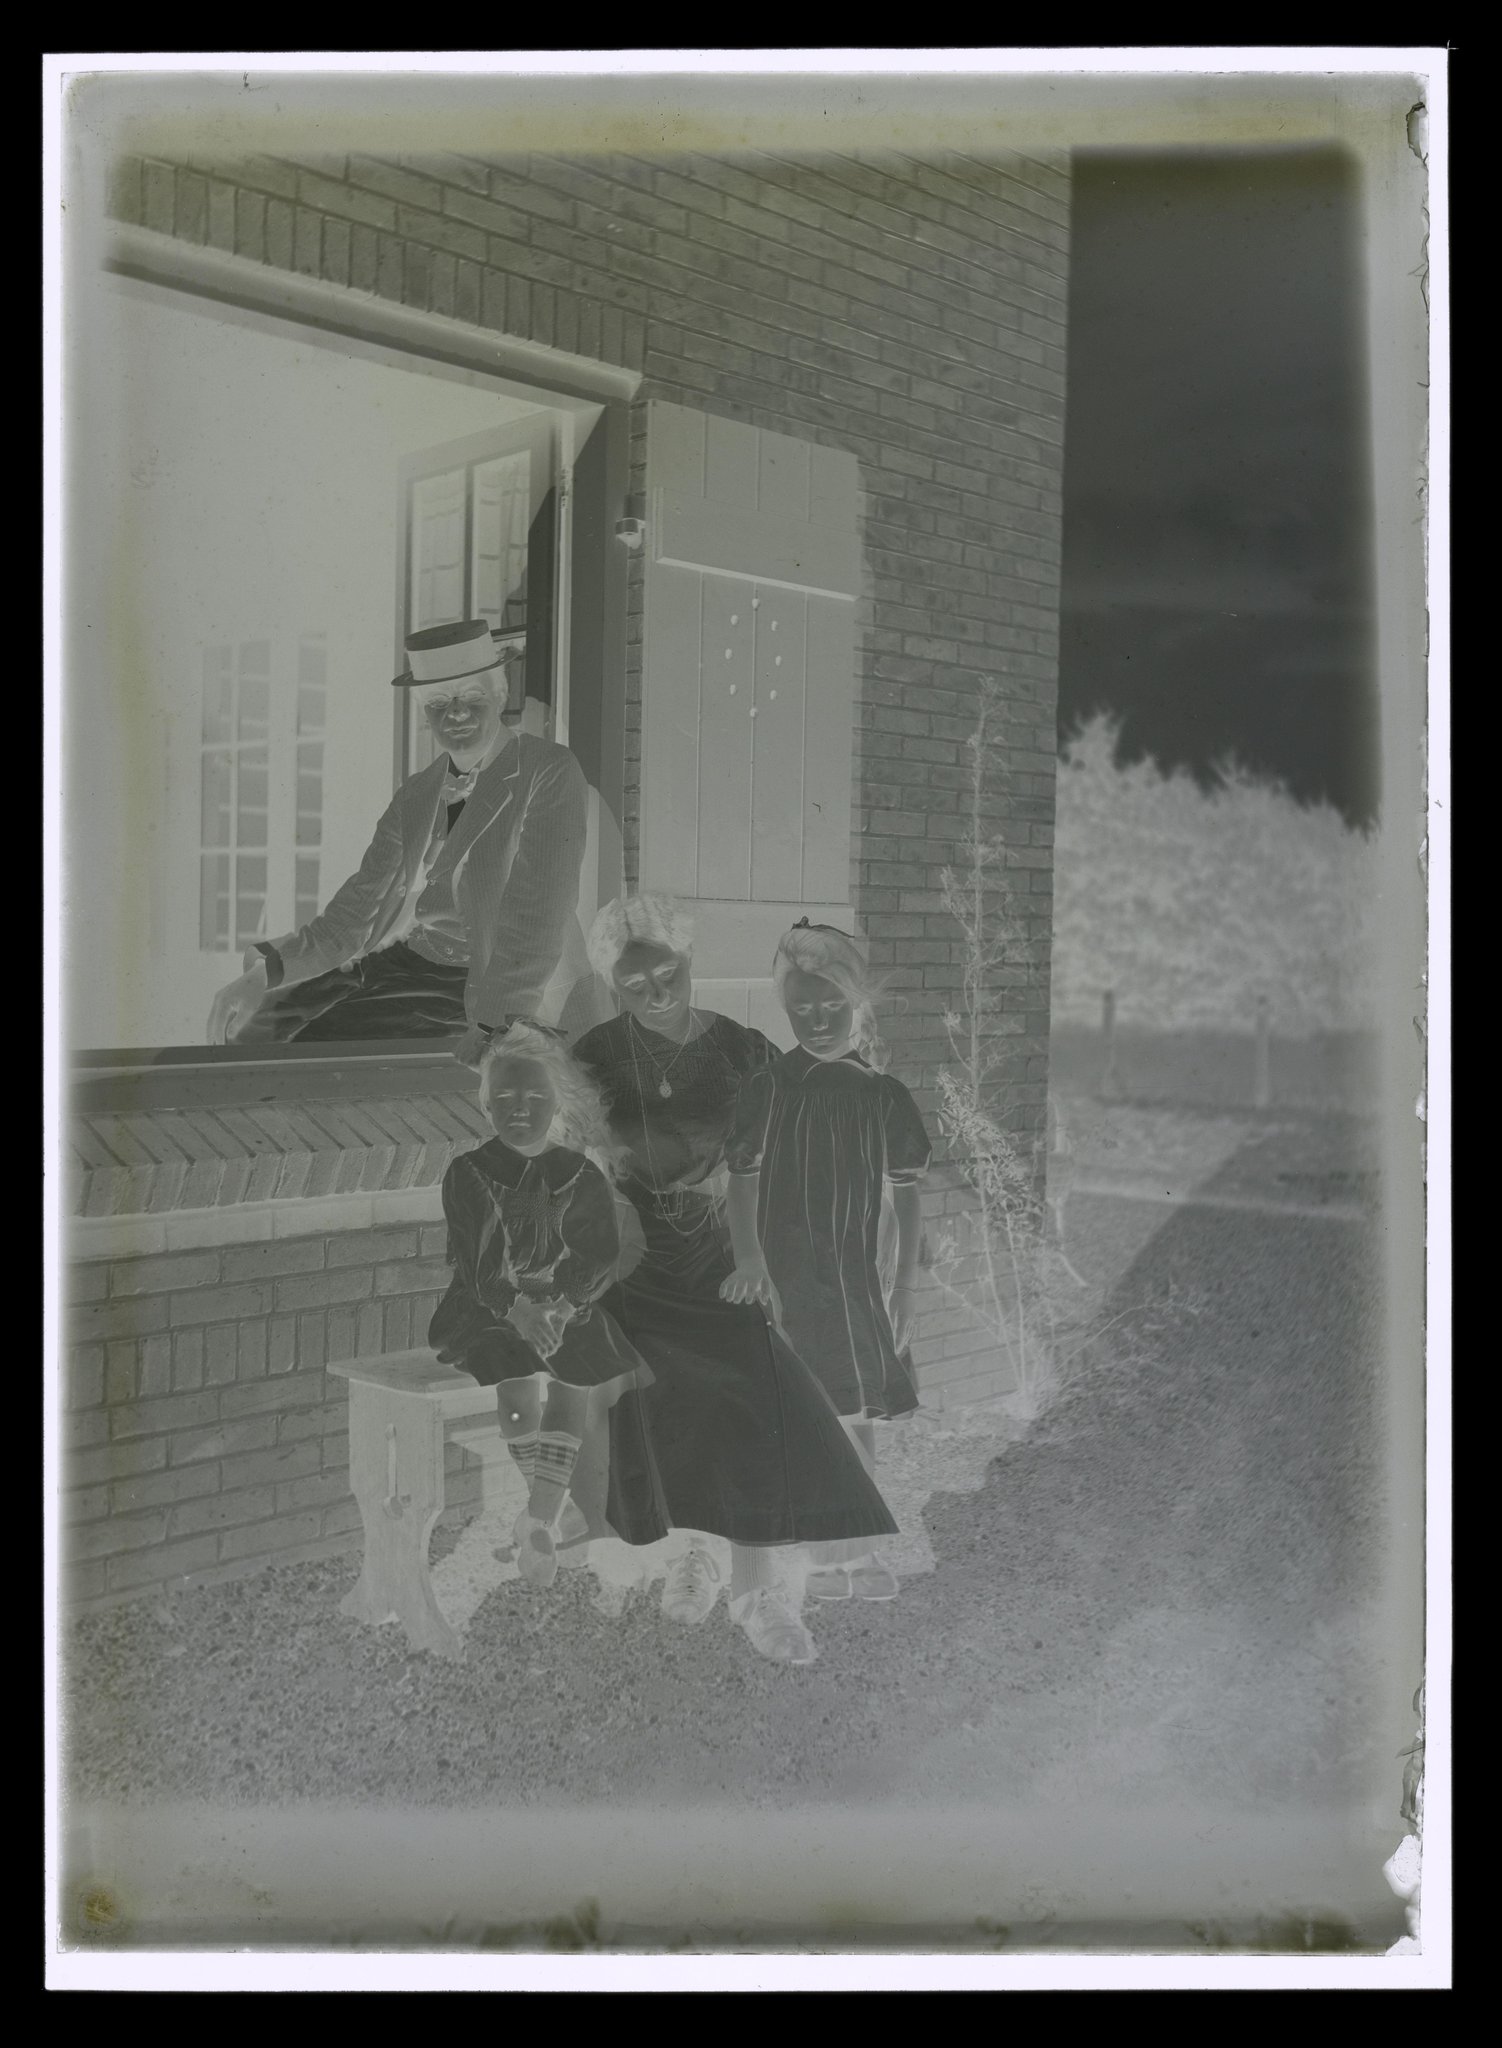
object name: glasnegatief, glasplaatnegatief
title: Portret van Elsa Diepenbrock zittend met dochters Thea en Joanna en Alphons Diepenbrock in het raamkozijn van huis 'Holtwick' te Laren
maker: wouterus gijsbertus hondius van den broek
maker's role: amateurfotograaf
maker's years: 1867-1913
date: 1911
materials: glass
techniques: gelatin glass negative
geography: laren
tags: elsa diepenbrock, amsterdam, alphons diepenbrock, family group, especially parents with their child(ren), historical persons, open window